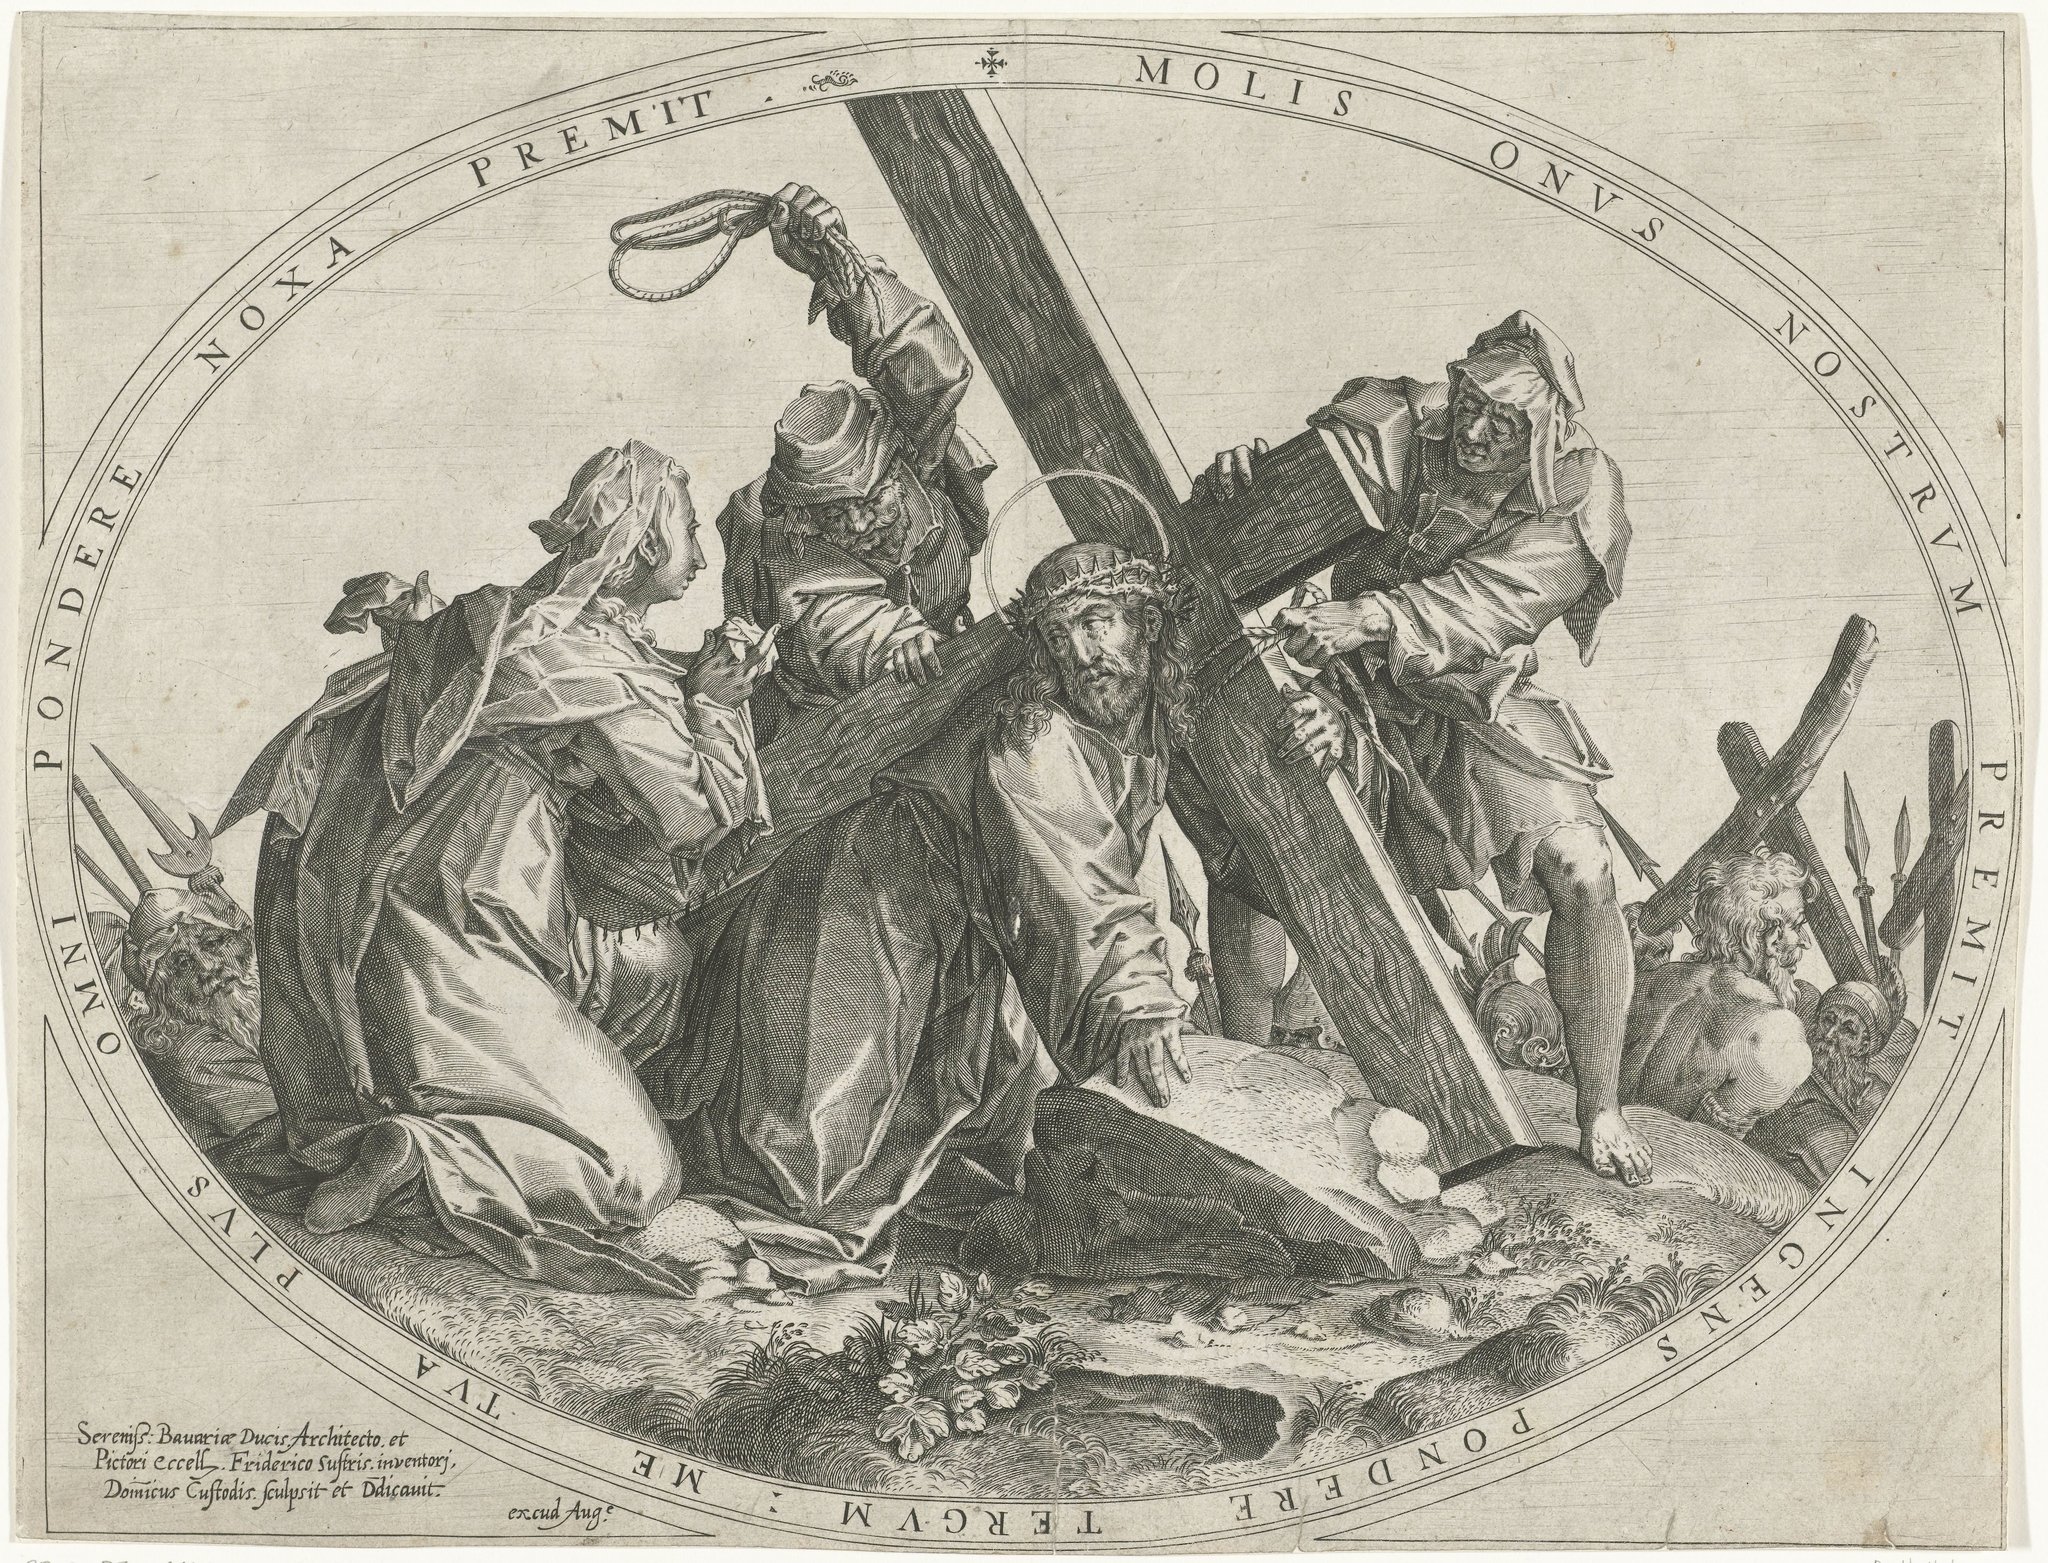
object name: print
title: Veronica biedt Christus een zweetdoek aan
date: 1579-1615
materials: paper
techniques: engraving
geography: augsburg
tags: christ meets veronica, who has a cloth to wipe christ's face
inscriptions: collector's mark: Lugt 2228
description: Christus bezwijkt onder het kruis, twee mannen slaan hem met touwen en trekken hem verder. Veronica knielt naast hem en biedt hem een zweetdoek aan. Voorstelling in liggend ovaal met randschrift in het Latijn.